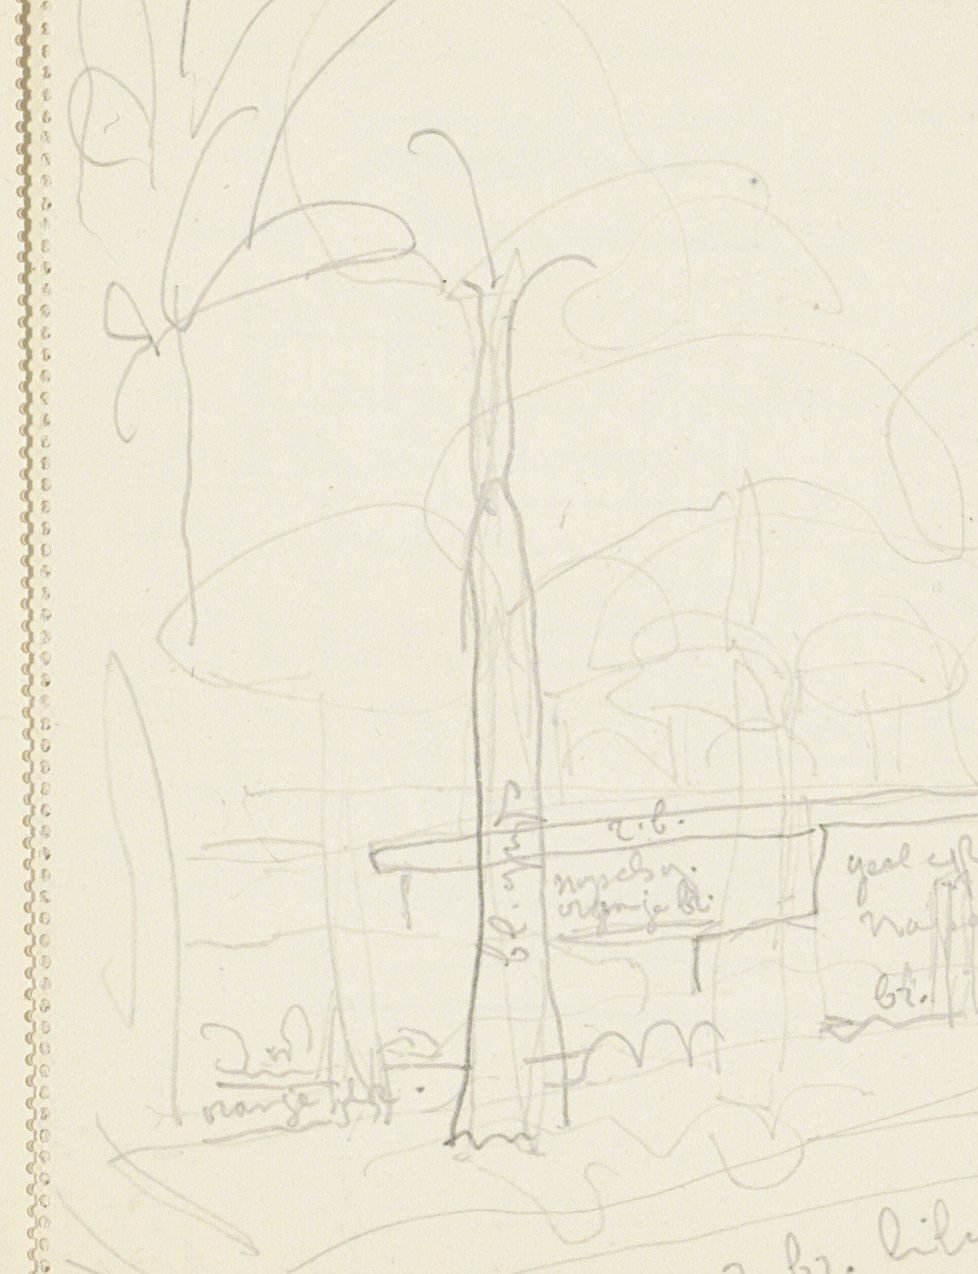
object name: sketchbook leaf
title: Landschap met palmbomen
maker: reijer stolk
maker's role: draughtsman, print maker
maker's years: 1896-1945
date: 1916-1945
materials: paper, pencil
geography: africa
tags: landscapes, trees: palm-tree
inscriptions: kleurnotitie, handgeschreven in potlood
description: Blad 25 recto uit een schetsboek met 60 bladen.